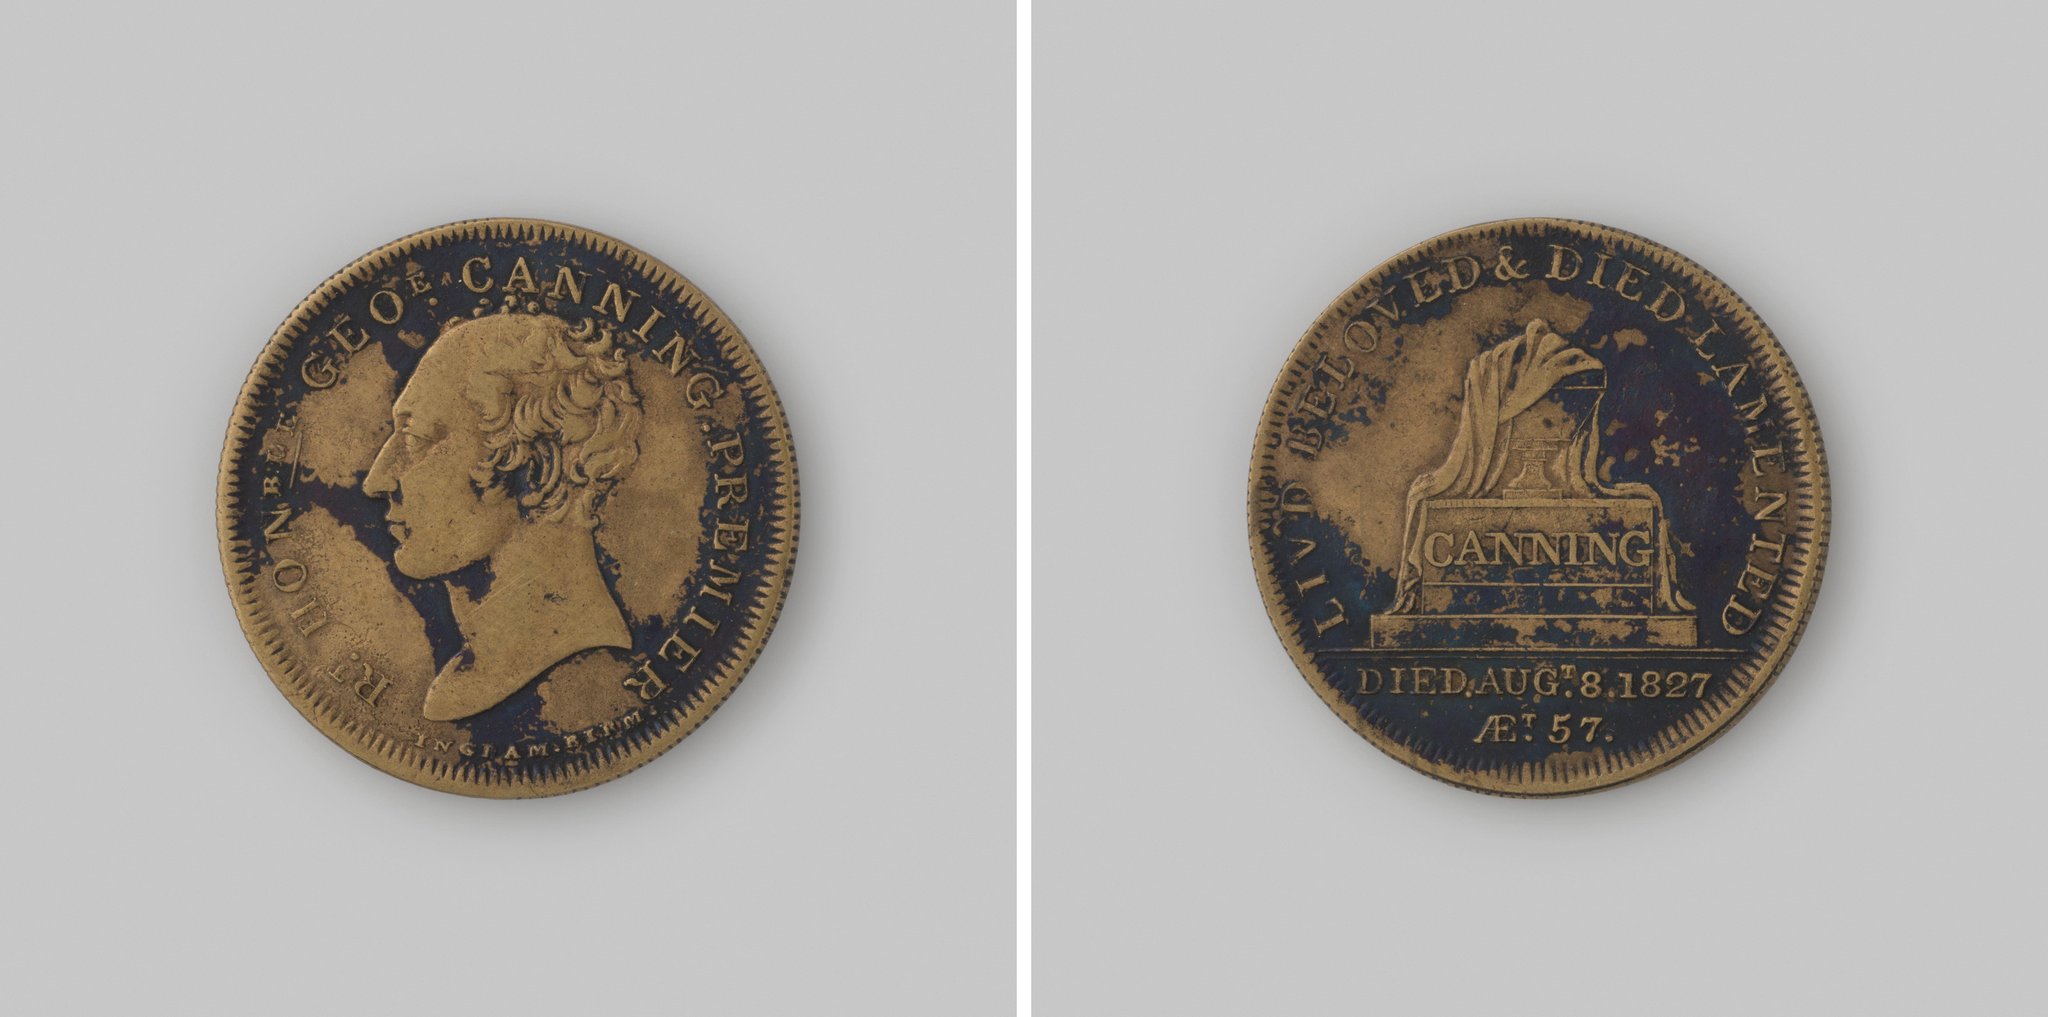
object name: history medal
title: Overlijden van George Canning 1827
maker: thomas wells ingram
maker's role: die cutter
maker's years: 1799-1844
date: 1827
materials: brass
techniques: striking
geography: birmingham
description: Messing penning, op de voorzijde het portret van Canning naar links met omschrift, op de keerzijde een grafmonument met urn en sluier, met omschrift en afsnedetekst.